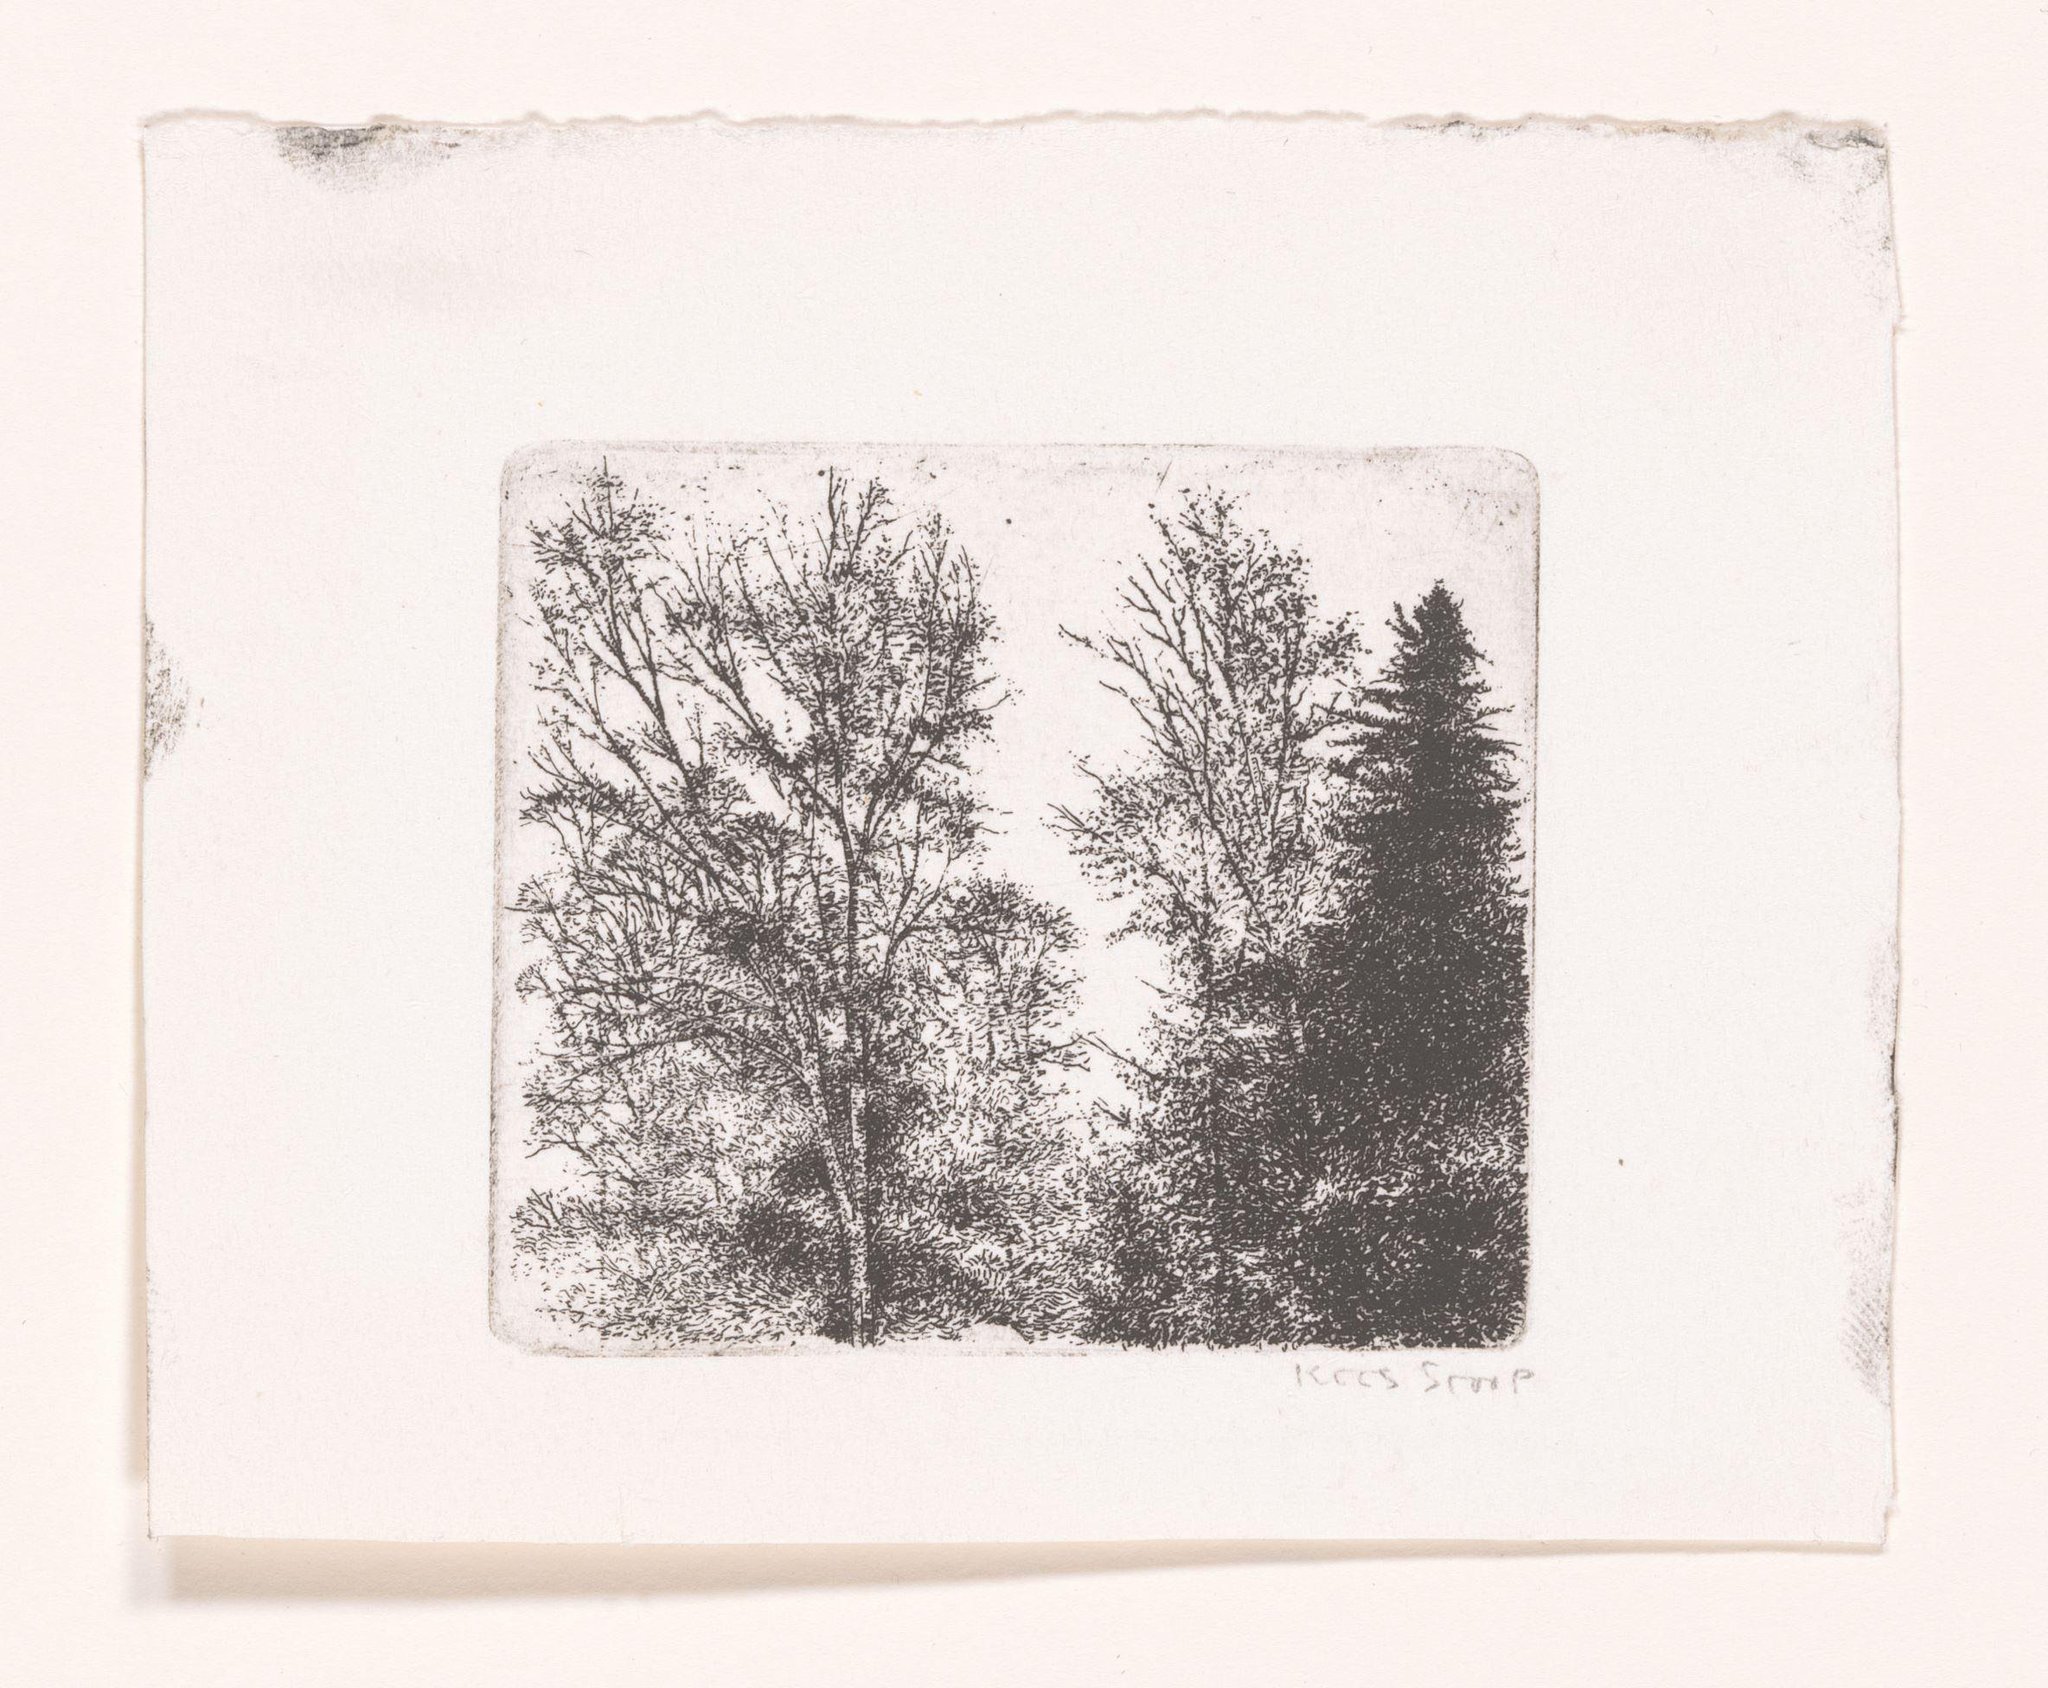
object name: print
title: Boomtoppen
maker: kees stoop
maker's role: draughtsman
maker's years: 1929-2019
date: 1944-1990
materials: paper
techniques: etching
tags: trees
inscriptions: signature: ‘KEES STOOP’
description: Boomtoppen van loofbomen en een naaldboom.